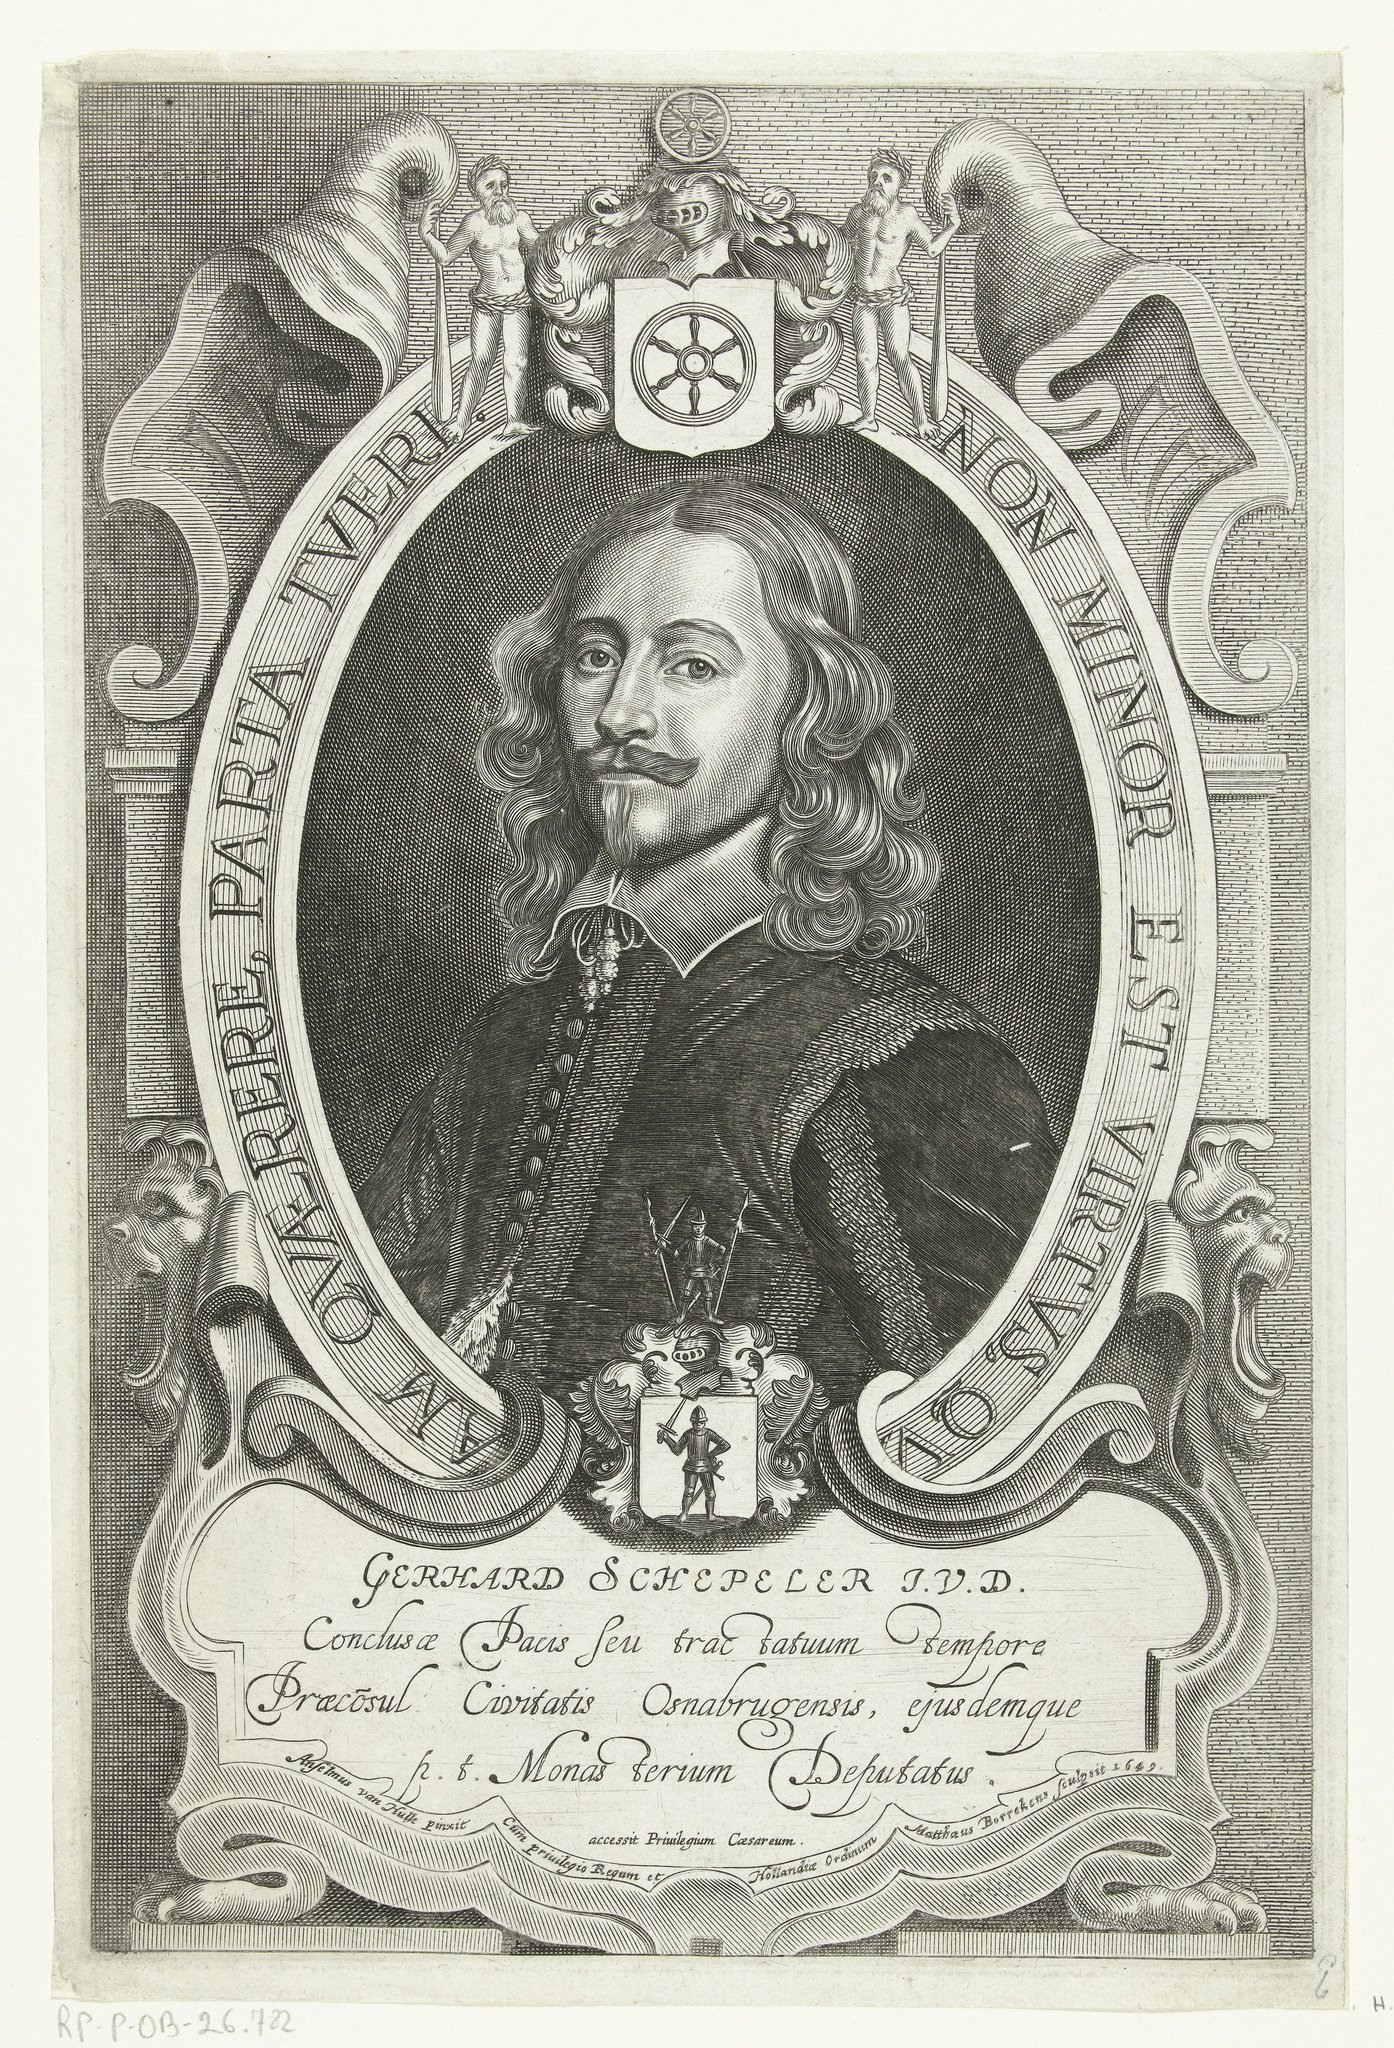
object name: print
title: Portretten van onderhandelaars bij de Vrede van Munster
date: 1649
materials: paper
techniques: engraving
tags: gerhard schepeler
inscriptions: collector's mark: Lugt 2228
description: Gerhard Schepeler, burgemeester van Osnabrück en onderhandelaar bij de Vrede van Munster. Portret in ovale lijst met buste naar links. De prent bevat een Latijns onderschrift in cartouche, een randschrift en ornament met wapen bovenaan en onderaan.